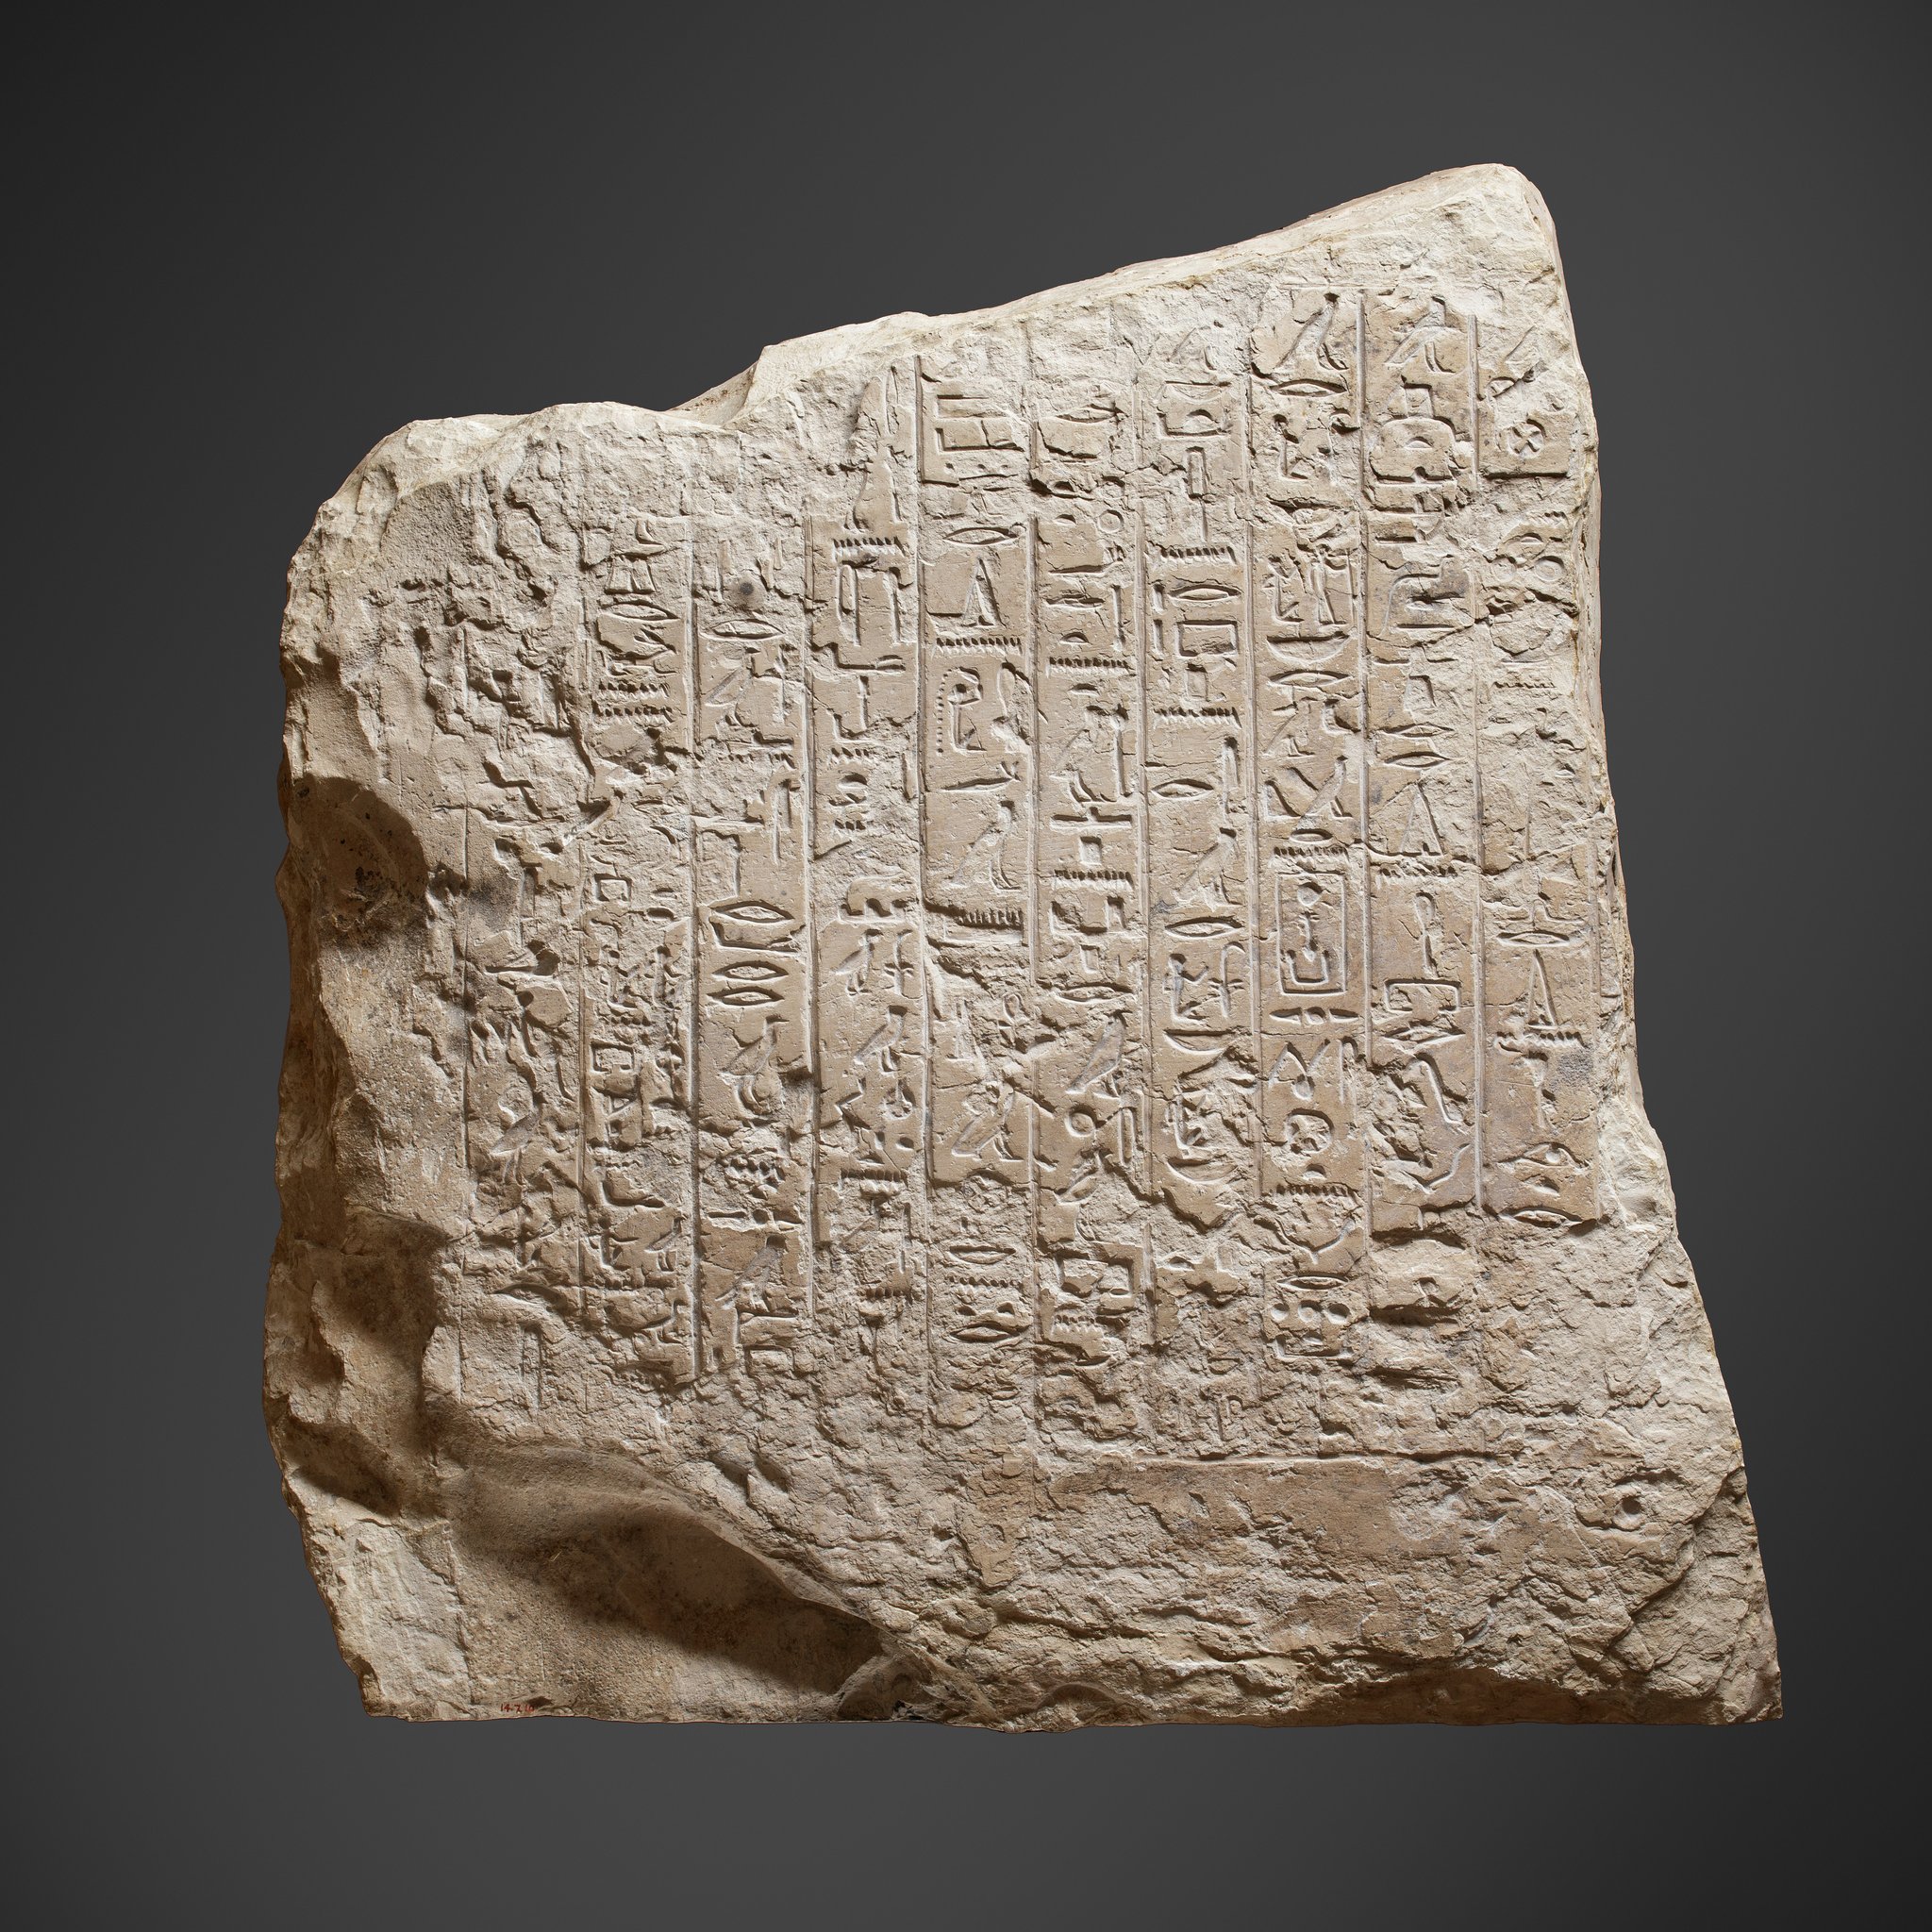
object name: relief, decree of king pepi ii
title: Decree of Pepi II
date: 2246-2152 BCE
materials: limestone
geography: egypt